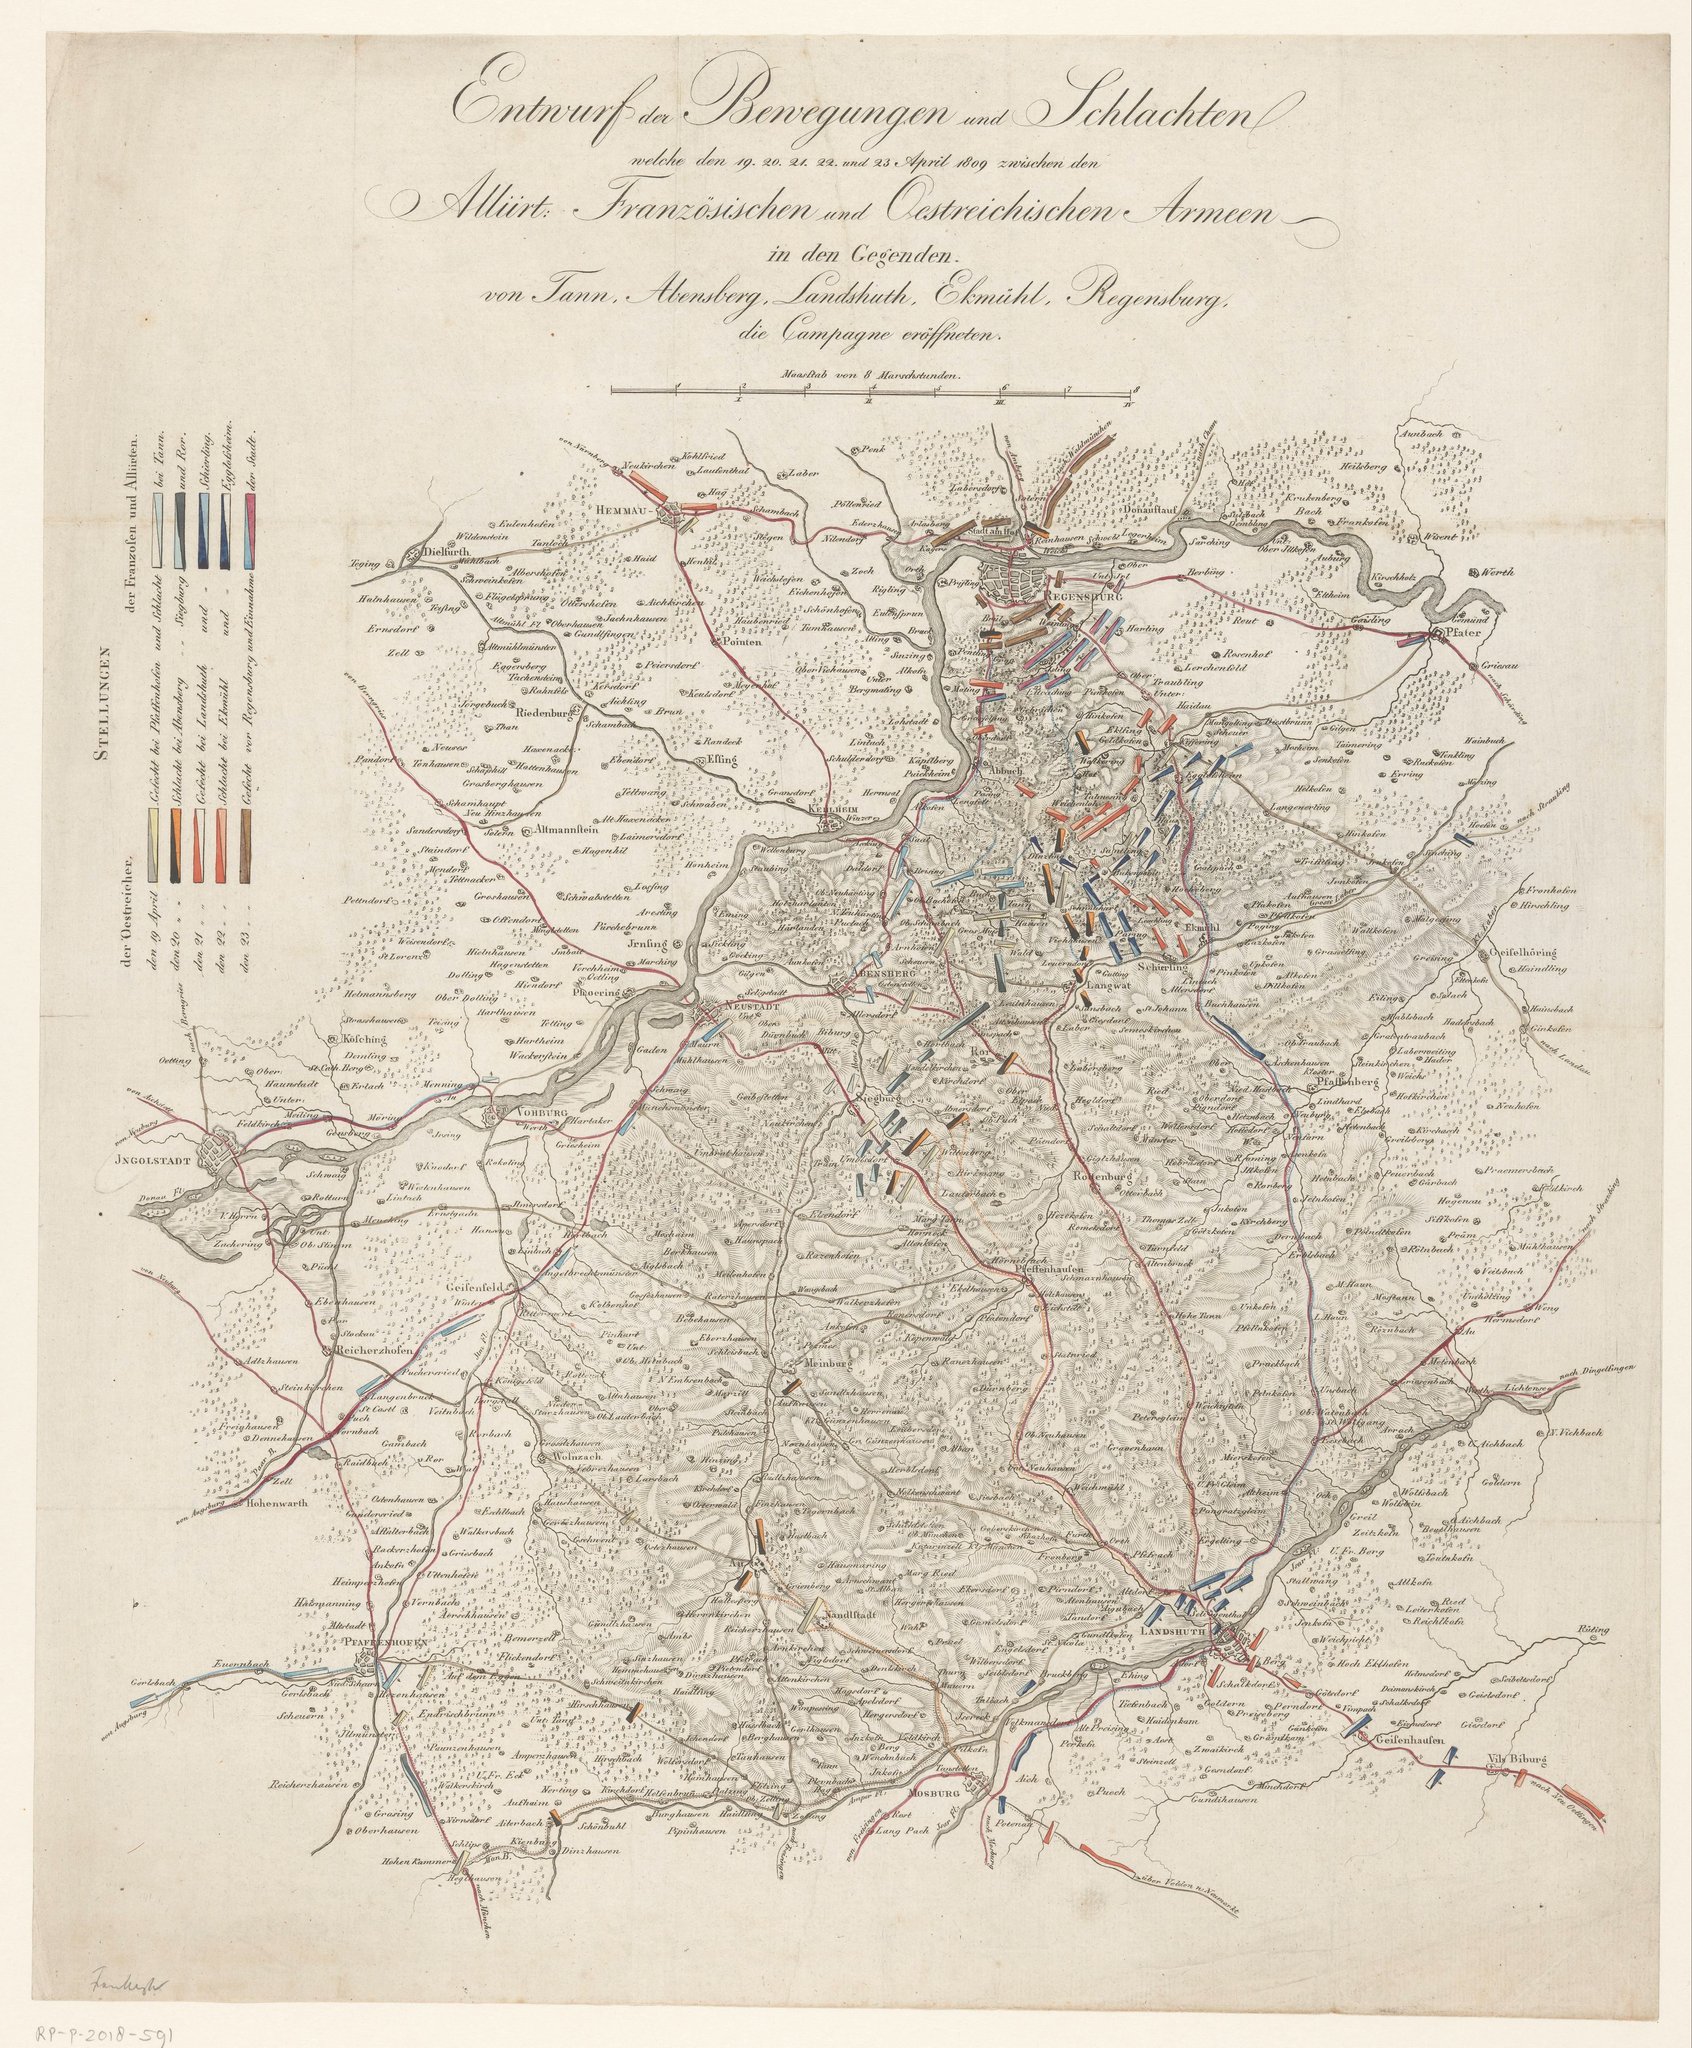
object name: map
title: Entwurf der Bewegungen und Schlachten welche den 19. 20. 21. 22. und 23. April 1809 zwischen den Alliirt: Französischen und Oestreichischen Armeen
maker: Anonymous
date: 1809-1875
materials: paper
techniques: engraving, etching, hand coloring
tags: battle (+ land forces), battle arrays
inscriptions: collector's mark: Lugt 2228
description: Kaart van het gebied in Beieren tussen Regensburg, Landshut en Ingolstadt waarop in kleuren de posities van de geallieerde en Franse troepen zijn aangegeven, in de dagen 19-22 april, voorafgaand aan de slag bij Ratisbon (Regensburg) op 23 1809. Op de achterzijde een opgeplakte 'Bemerkung'.